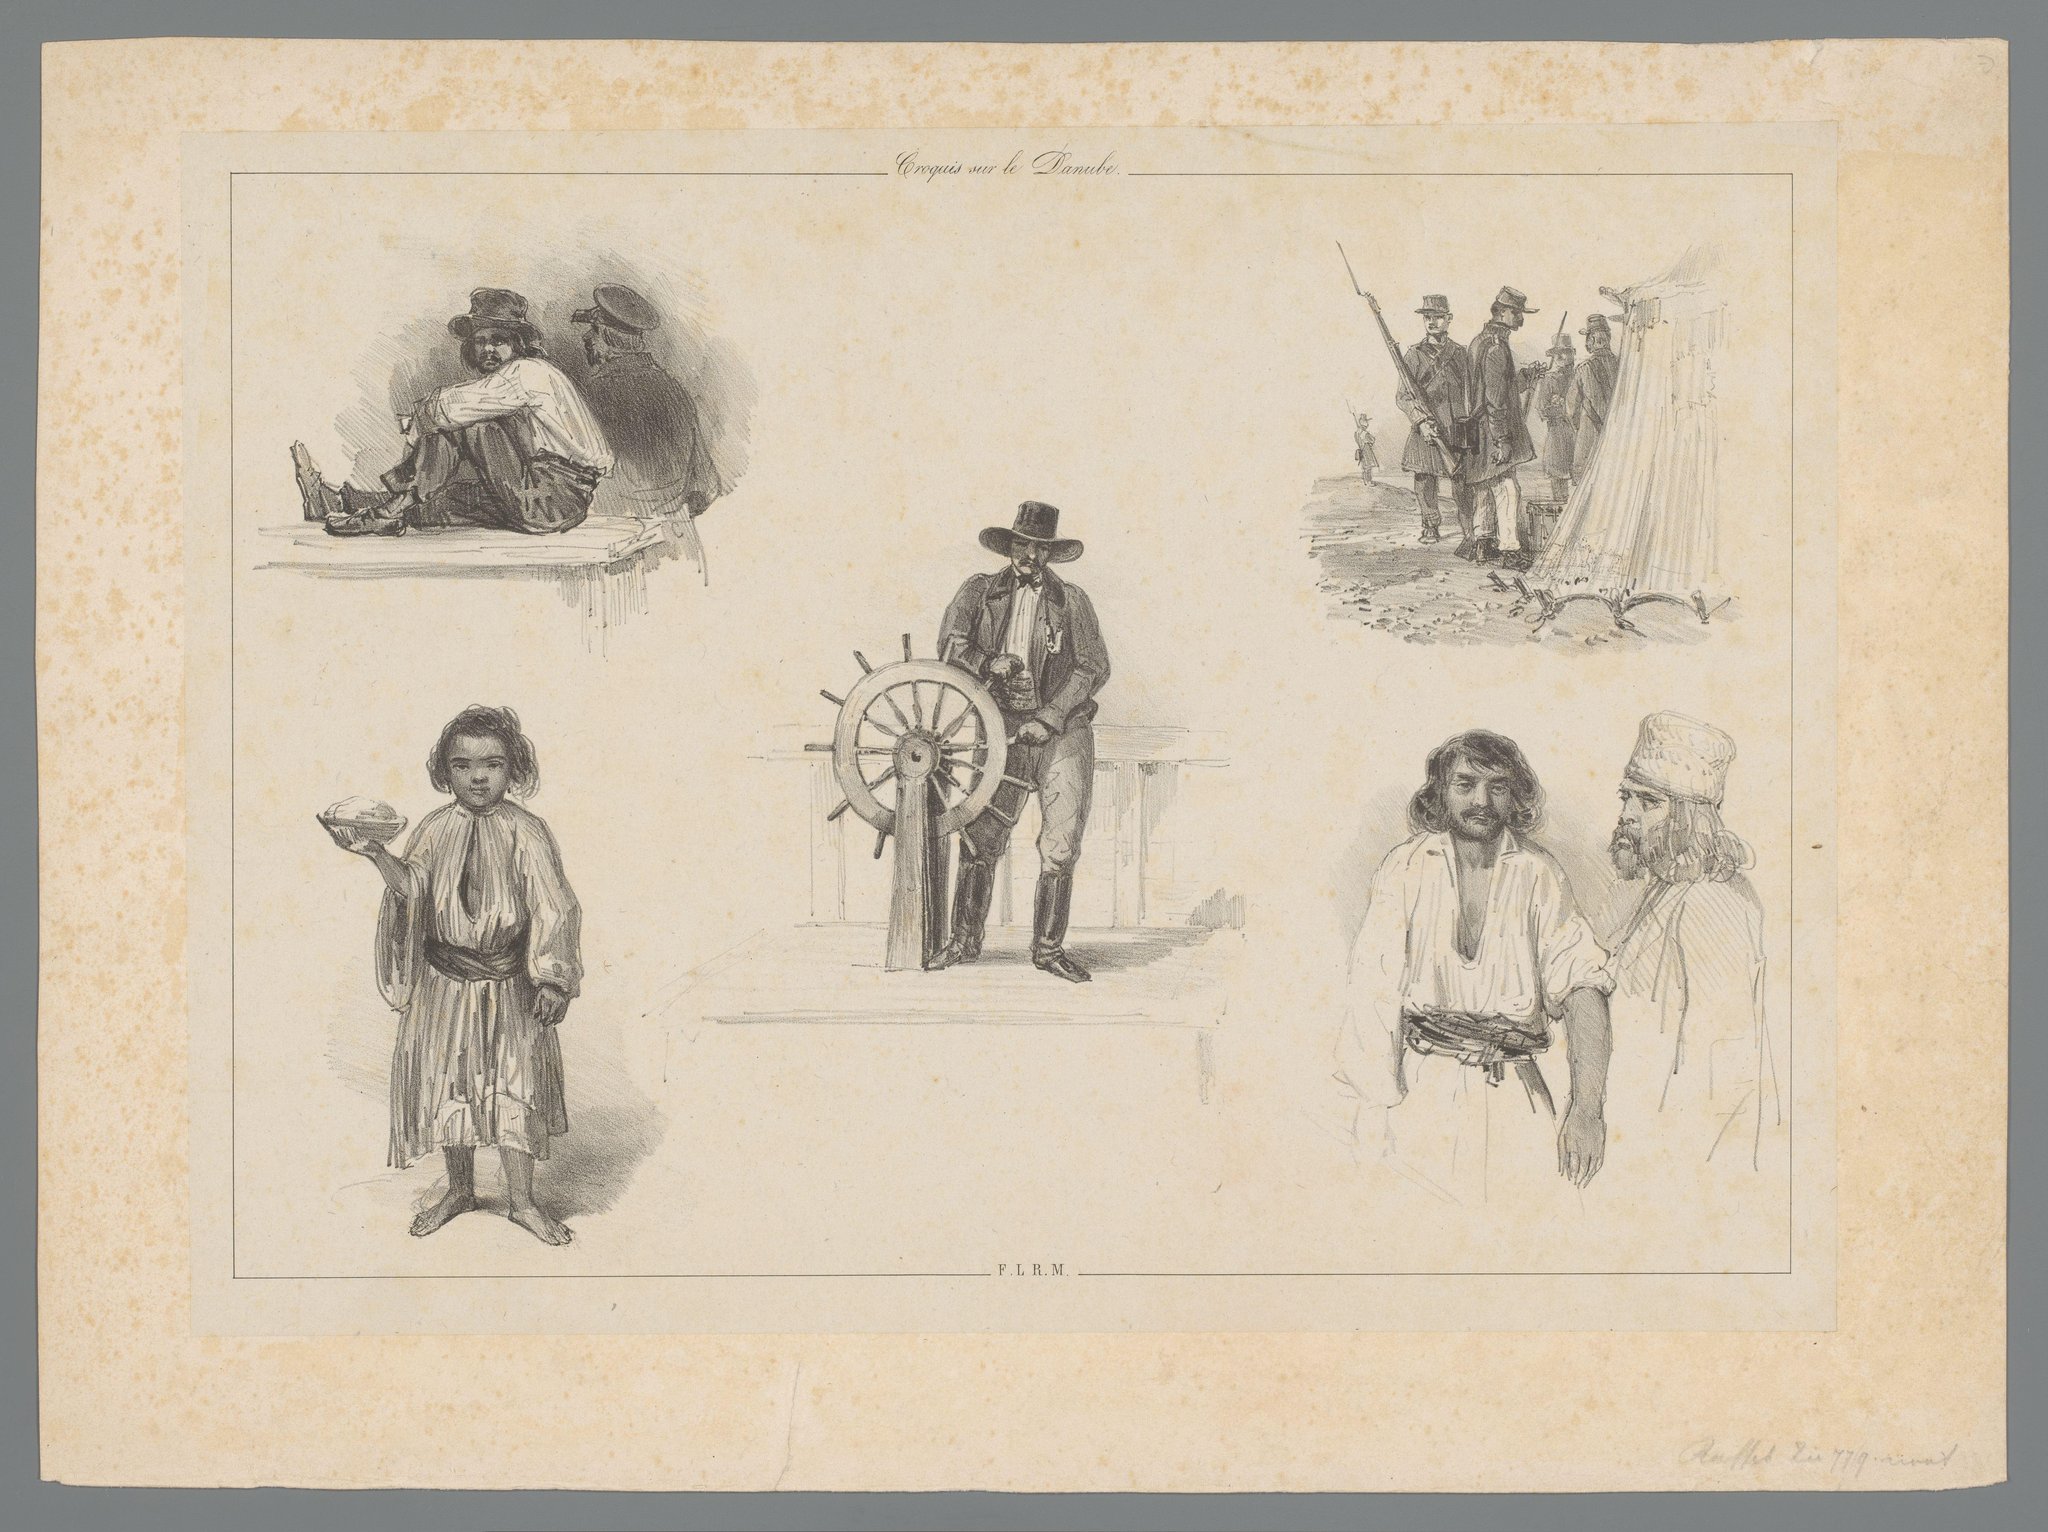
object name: print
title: F.L.R.M.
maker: denis auguste marie raffet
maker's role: draughtsman, print maker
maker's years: 1804-1860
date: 1848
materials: paper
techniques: lithograph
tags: at the helm (manoeuvering), child, the soldier; the soldier's life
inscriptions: collector's mark: Lugt 2228, collector's mark: Lugt 4660